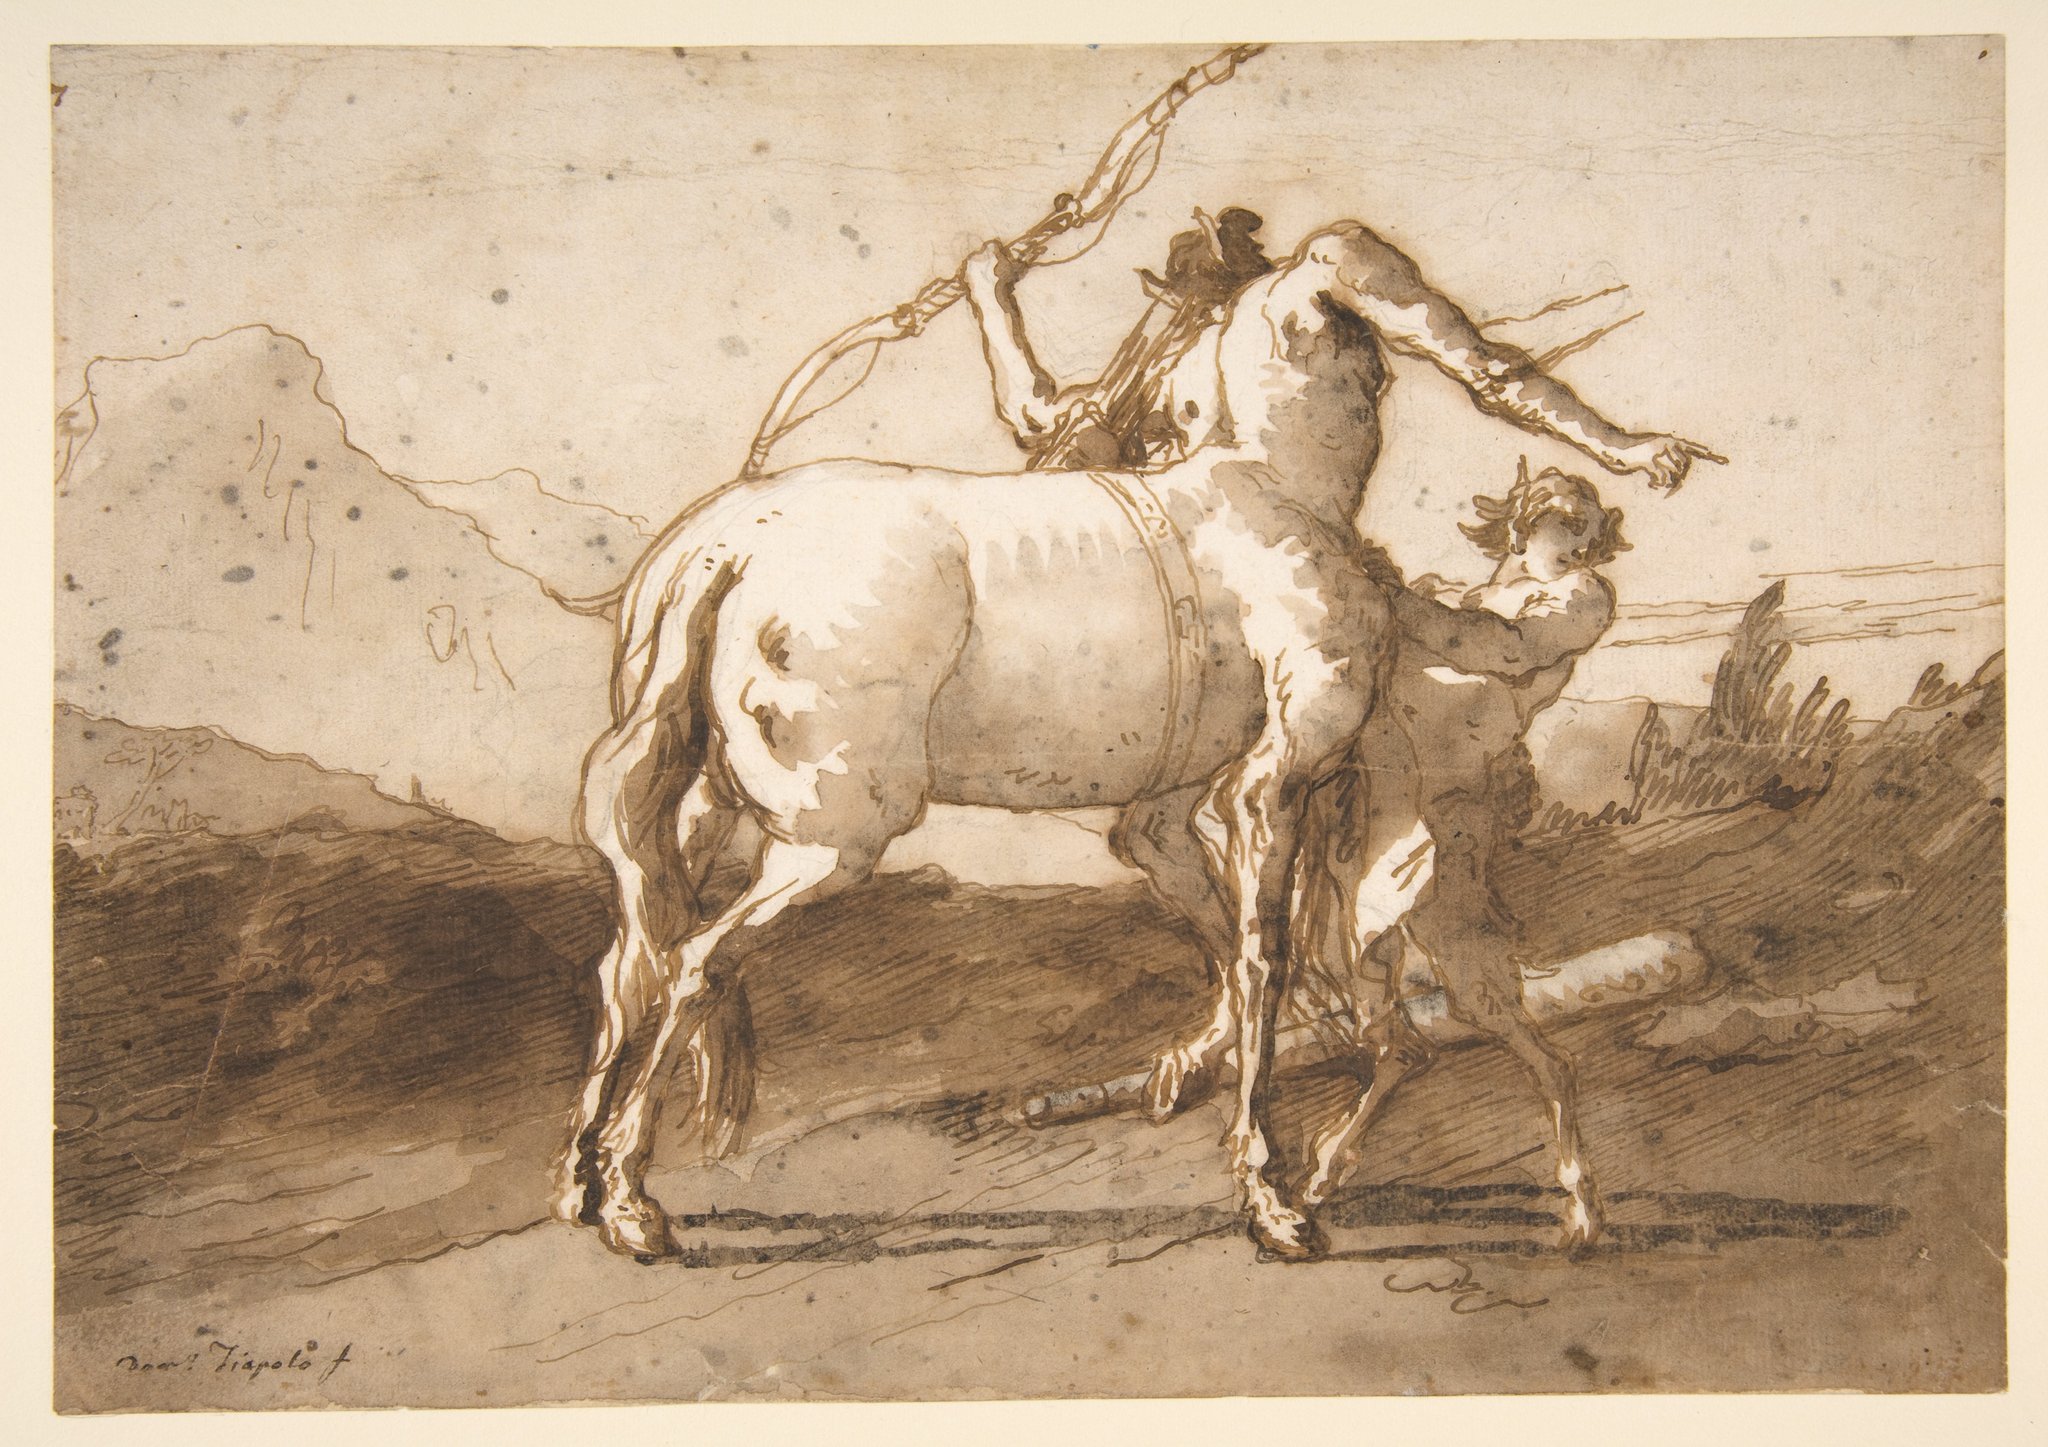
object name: drawing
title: A Centaur and a Satyr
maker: giovanni domenico tiepolo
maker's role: artist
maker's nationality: italian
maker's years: 1727-1804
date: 1727-1804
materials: graphite, ink, lead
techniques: brush, pen, wash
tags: bow and arrow,centaurs,satyrs